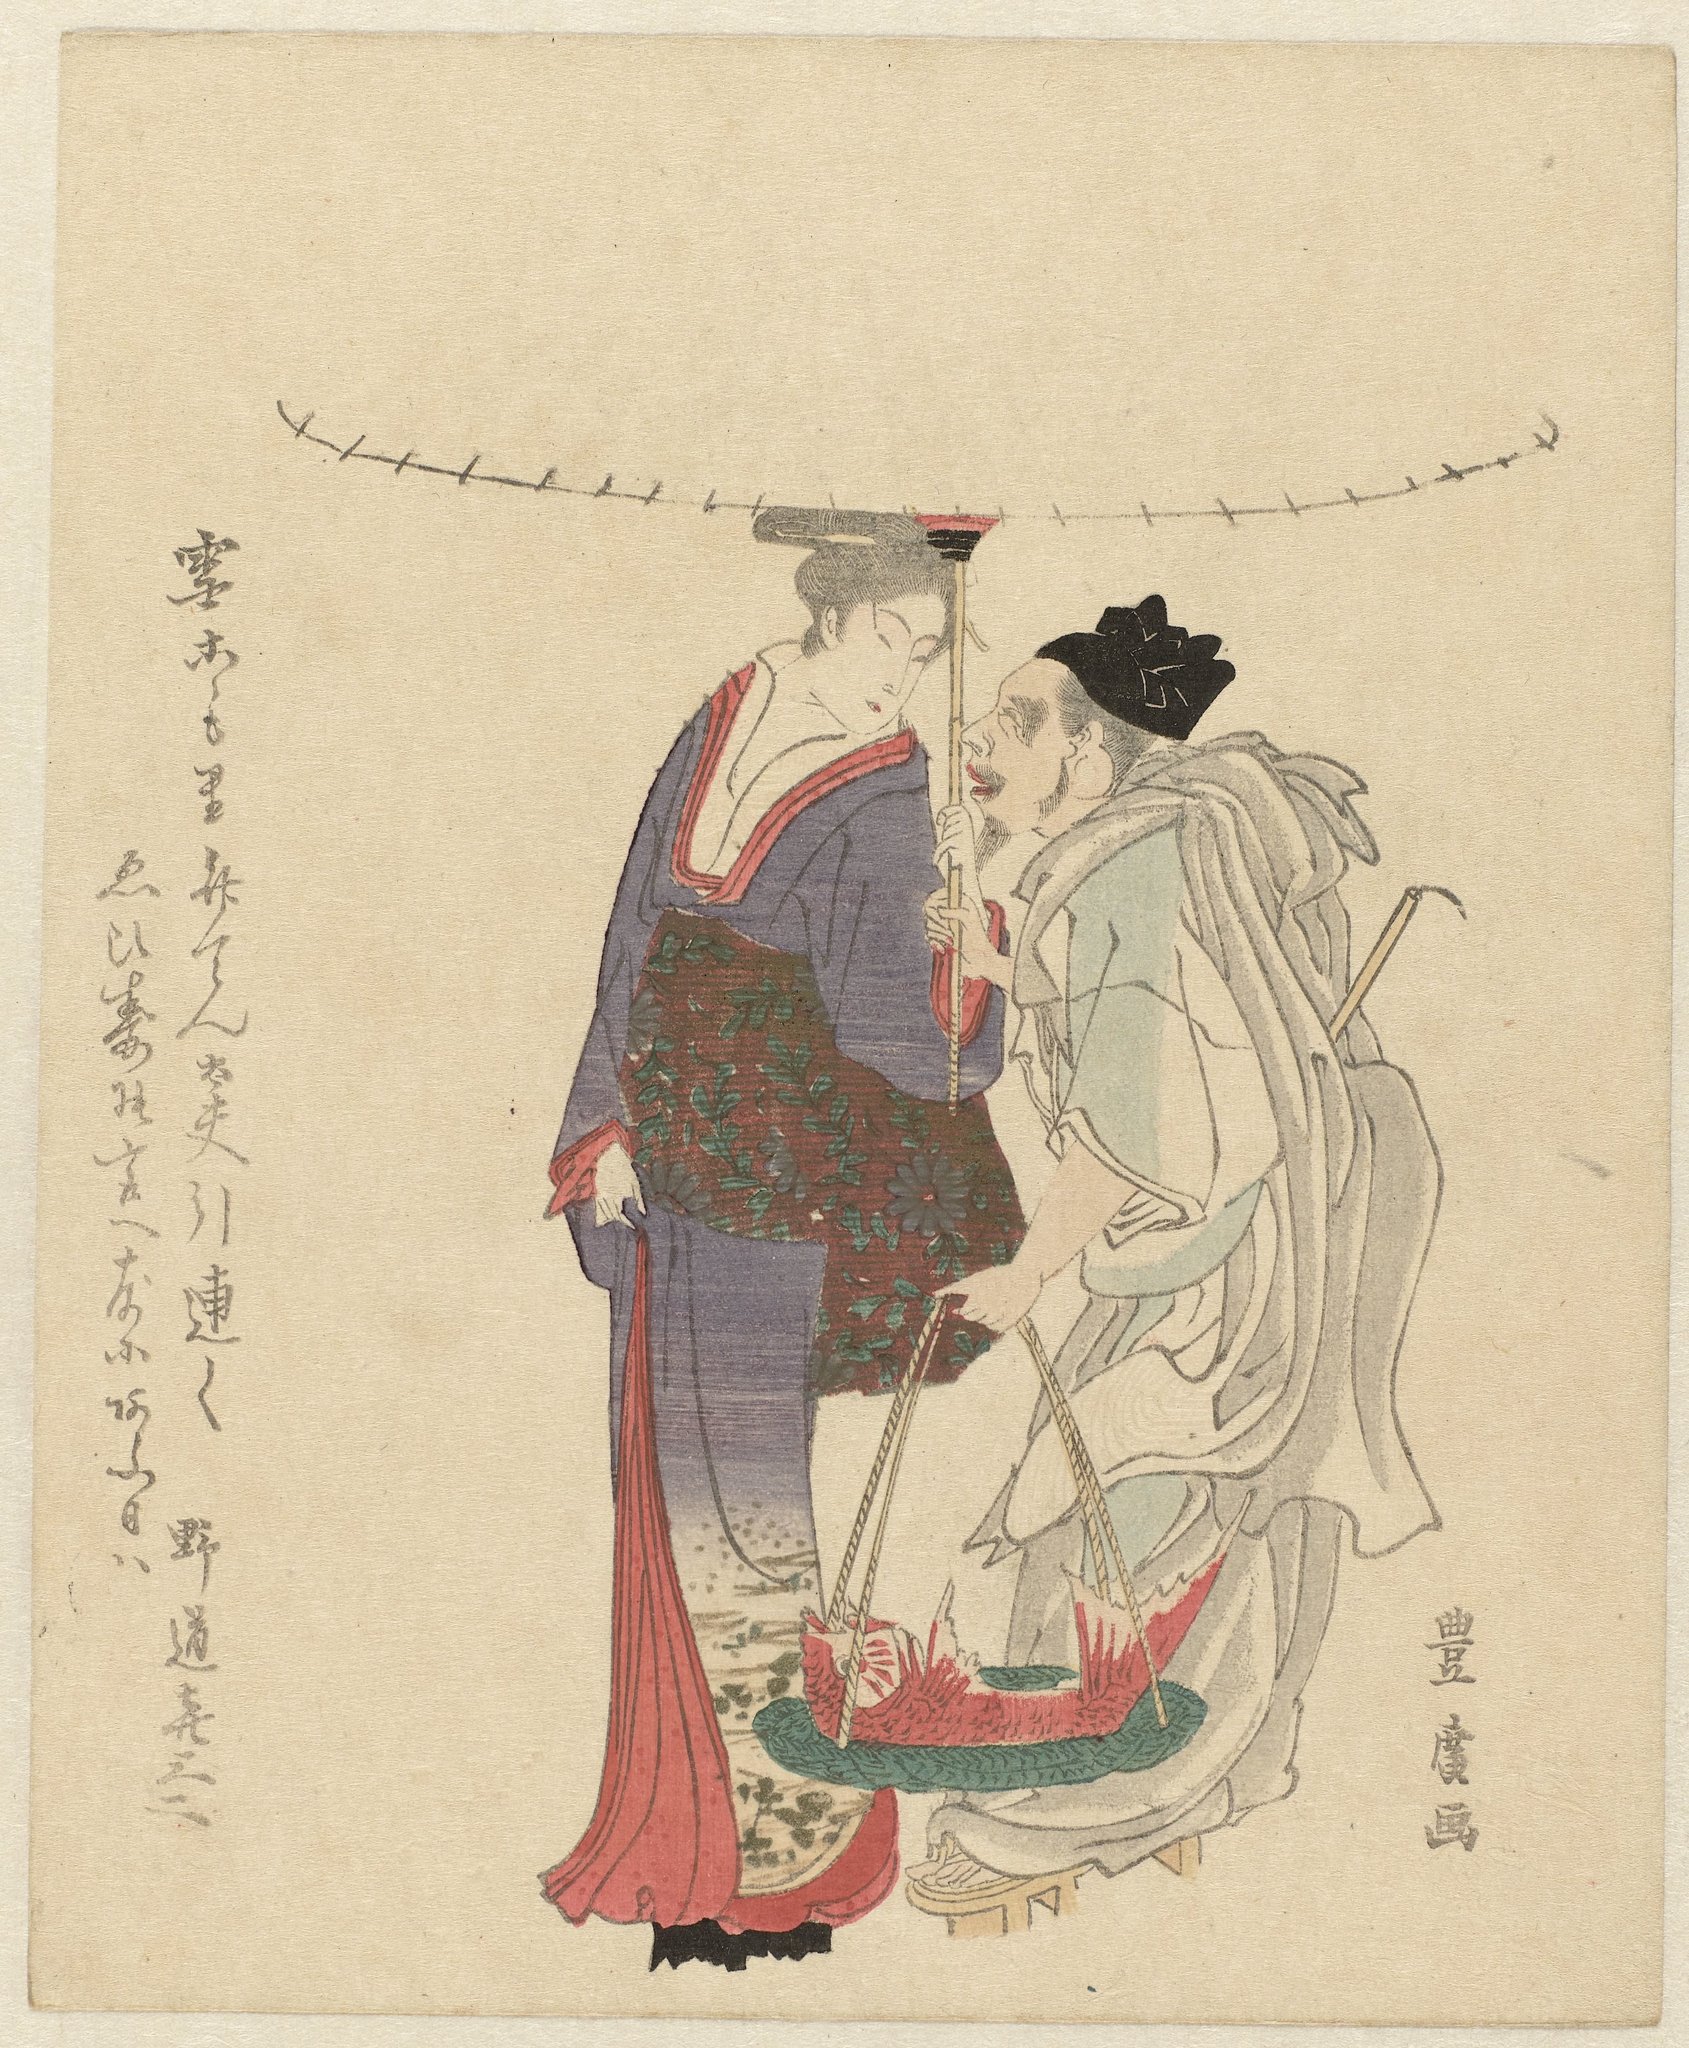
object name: print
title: De geluksgod Ebisu met een vrouw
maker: utagawa toyohiro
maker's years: 1773-1828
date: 1890-1900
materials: paper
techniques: blind stamped, woodcut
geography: japan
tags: shinto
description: Een surimono is een luxe uitgevoerde prent waarop beeld met één of meerdere gedichten gecombineerd is. Bij het drukken van een surimono werd vaak gebruik gemaakt van dikker papier, blinddruk en metaal pigmenten, zoals koper- en zilverpoeder. De prenten werden vaak in opdracht van dichters gemaakt en als exclusief geschenk aan vrienden en relaties gegeven.